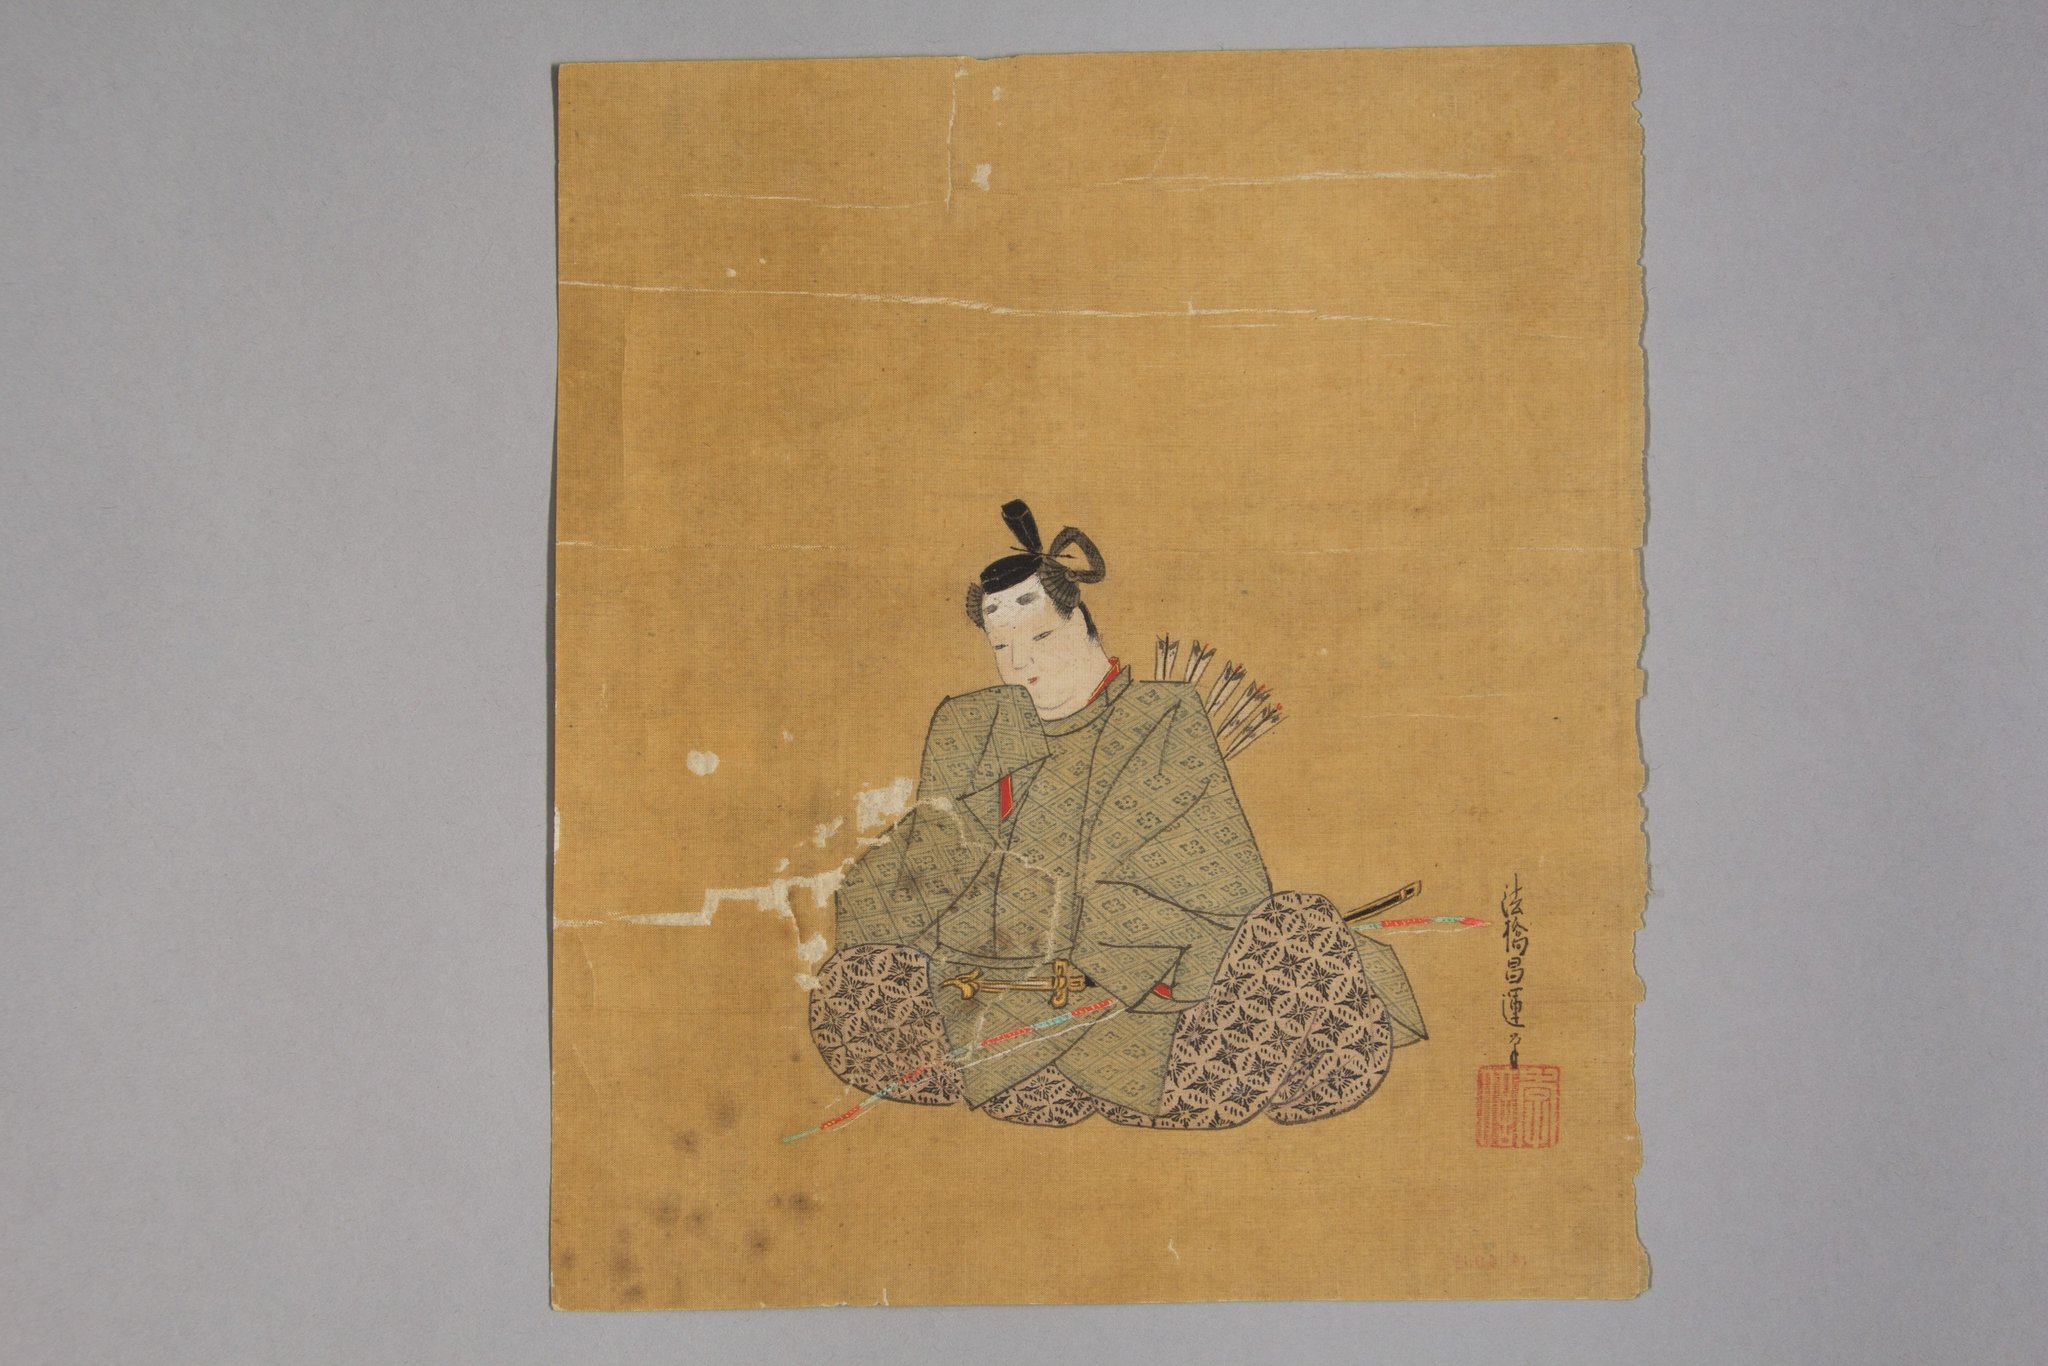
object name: painting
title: Immortal Poet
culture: japanese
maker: kano shōun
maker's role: artist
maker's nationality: japanese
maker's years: 1637-1702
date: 1601-1700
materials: ink, silk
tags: men,poets